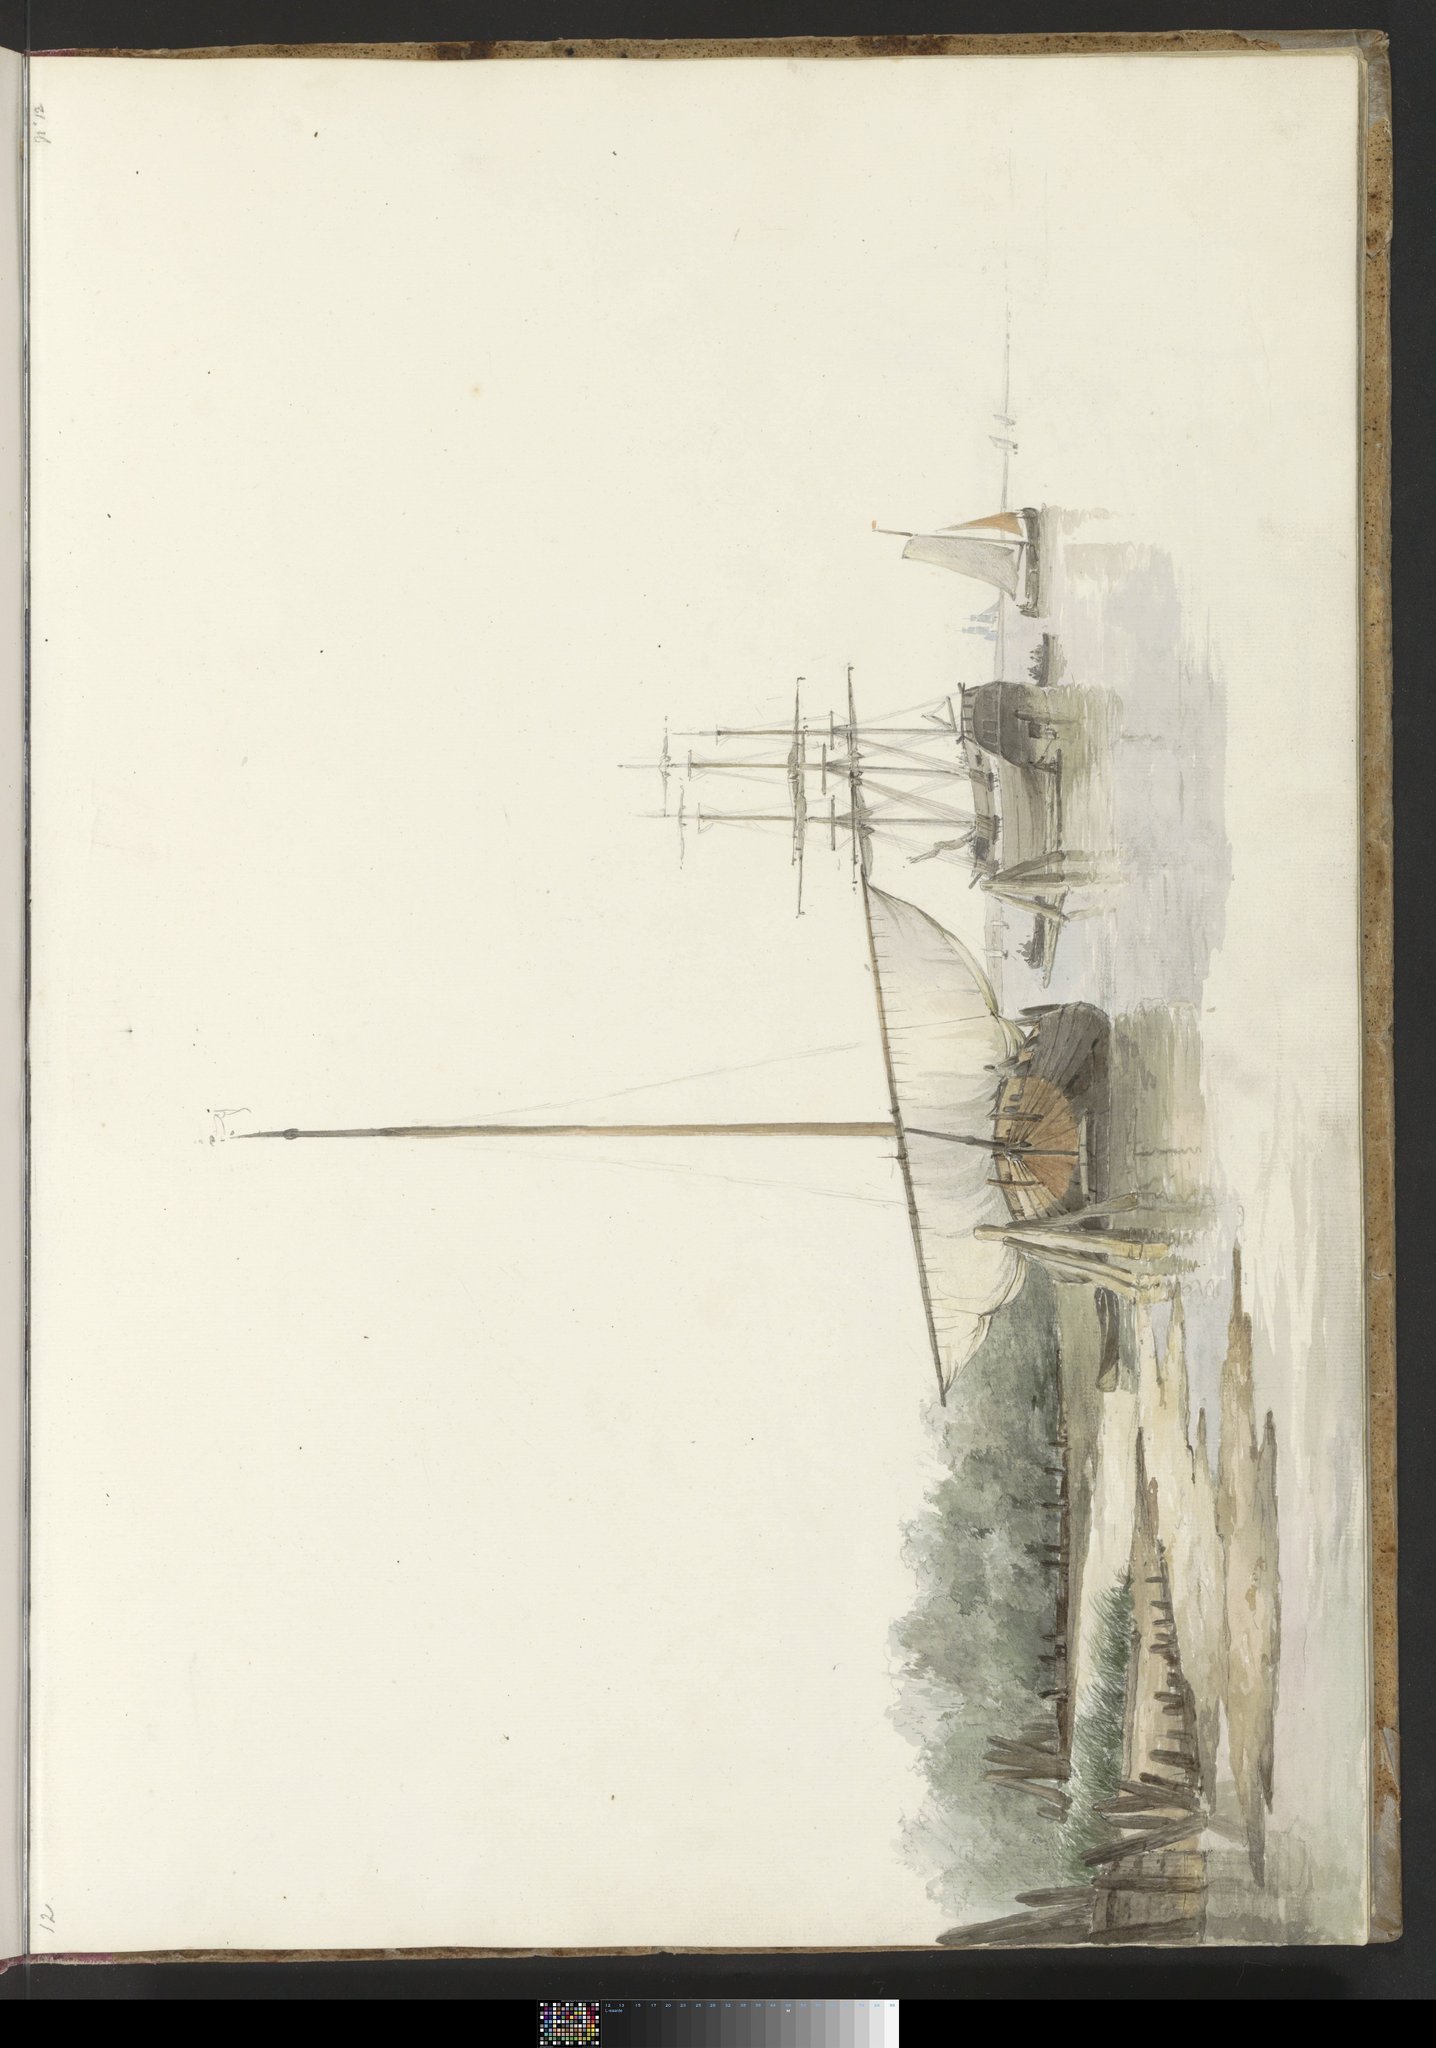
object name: sketchbook leaf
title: Zeilschepen voor anker bij een oever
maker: johannes christiaan schotel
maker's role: draughtsman, painter, print maker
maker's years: 1787-1838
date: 1797-1838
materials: paper, pencil, watercolor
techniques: brush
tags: sailing-ship, sailing-boat, river bank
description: Blad 12 recto uit een schetsboek met 65 bladen.